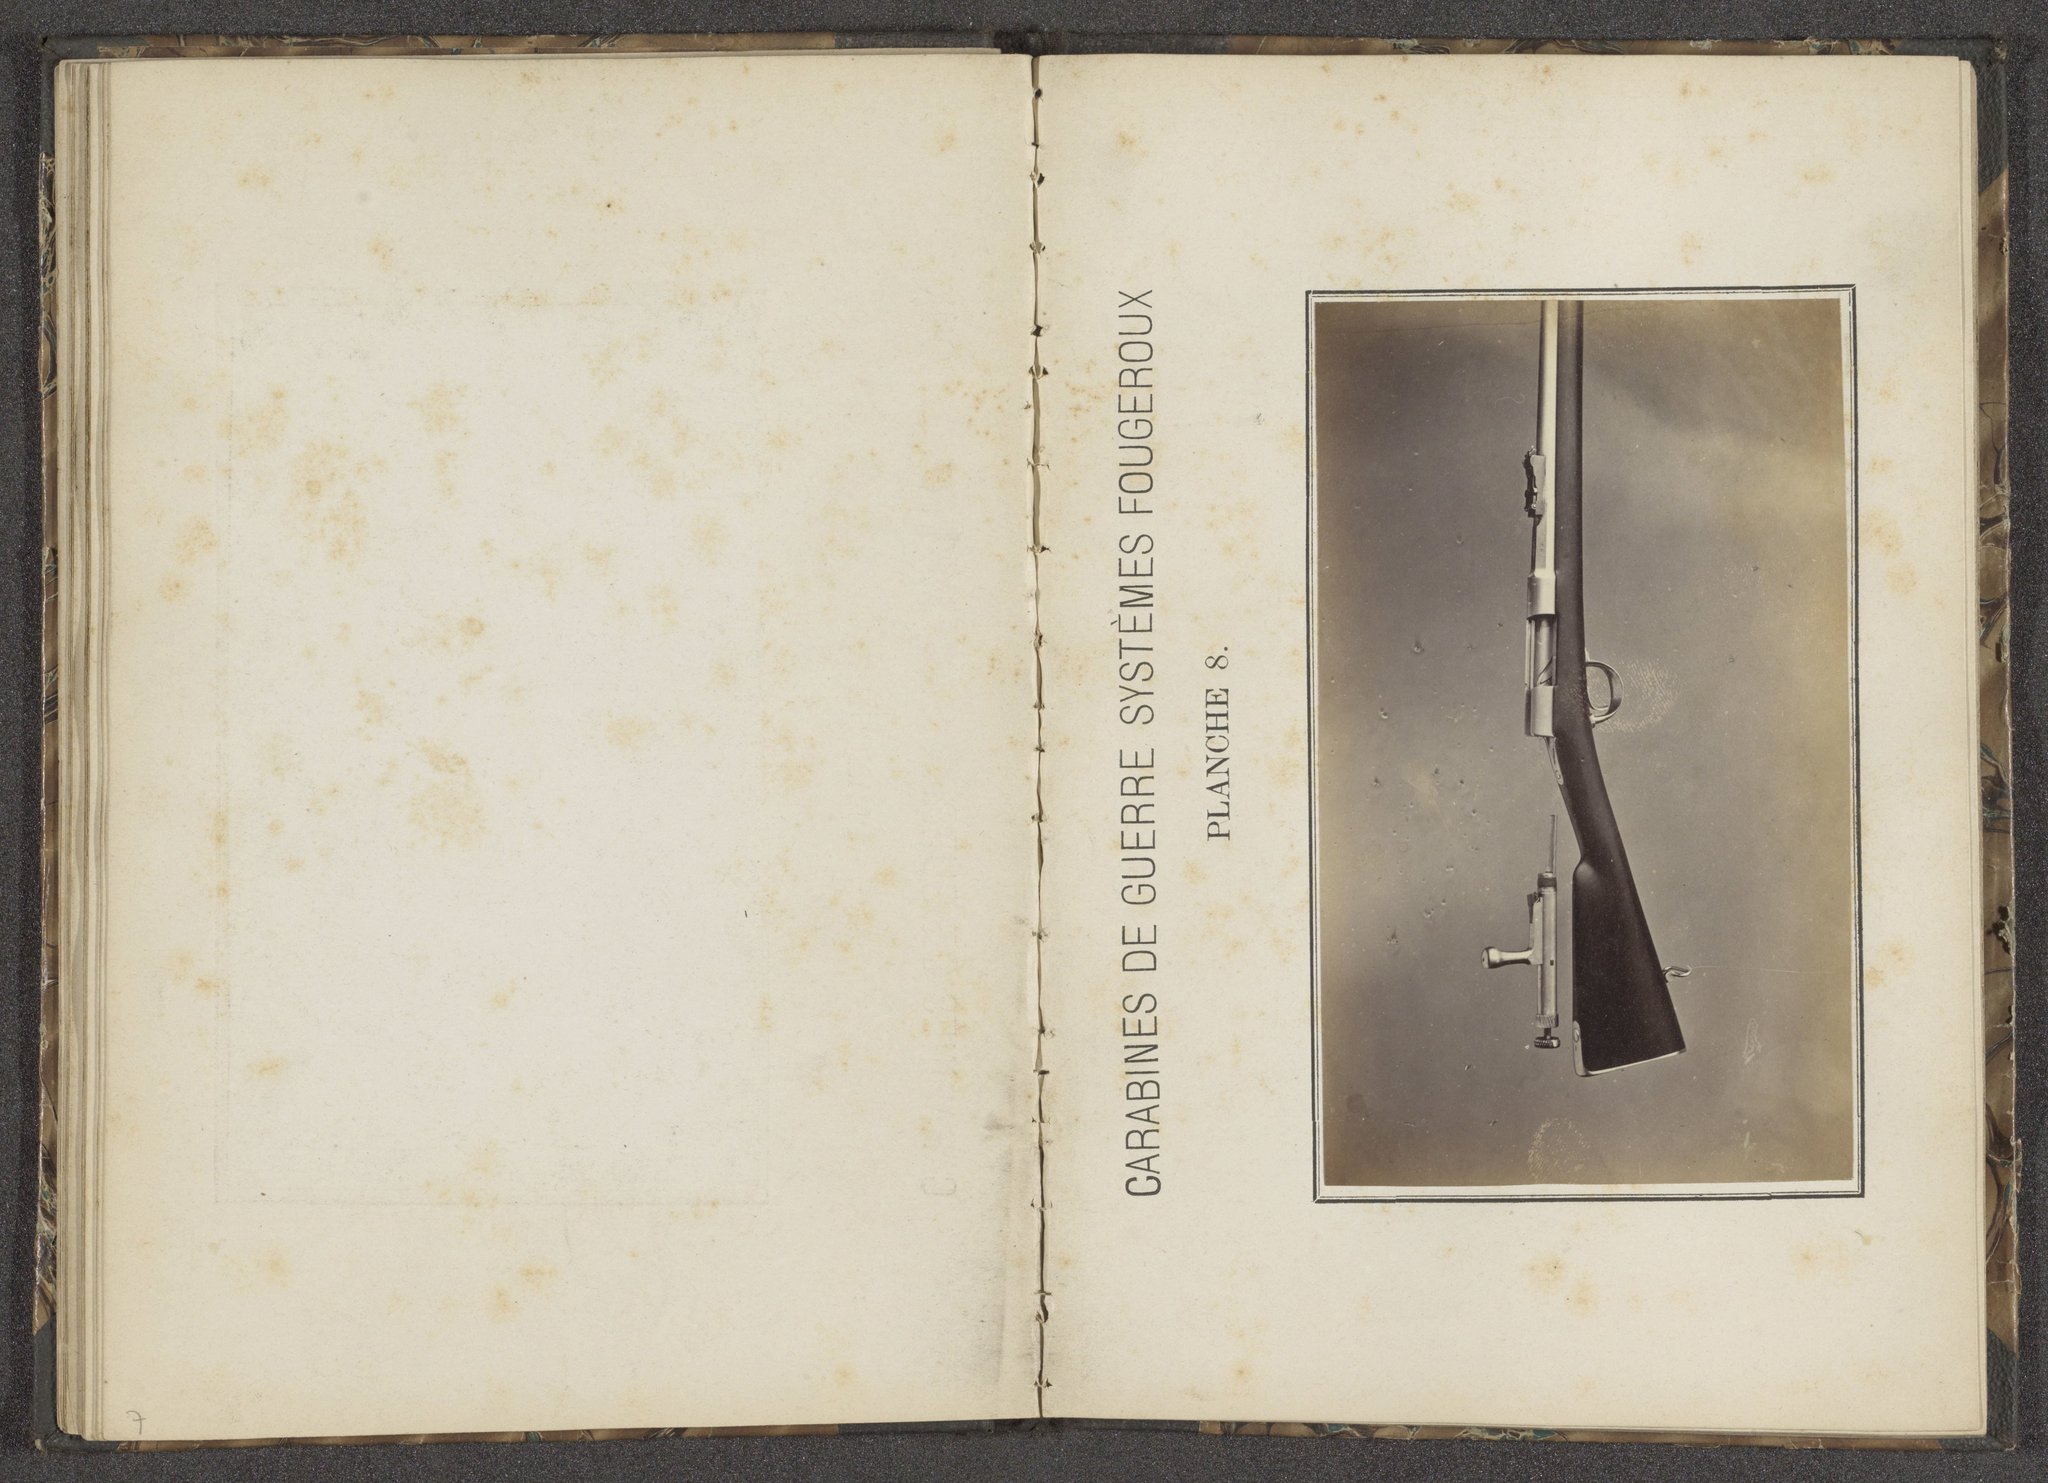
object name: page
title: Deel van een geweer en een losse veiligheidspal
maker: edouard magis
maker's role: fotograaf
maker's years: 1828-1906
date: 1857-1867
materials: photographic support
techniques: albumen print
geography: liège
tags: firearms: rifle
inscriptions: inscription: ‘Carabines de guerres systèmes Fougeroux’, number: ‘Planche 8.’